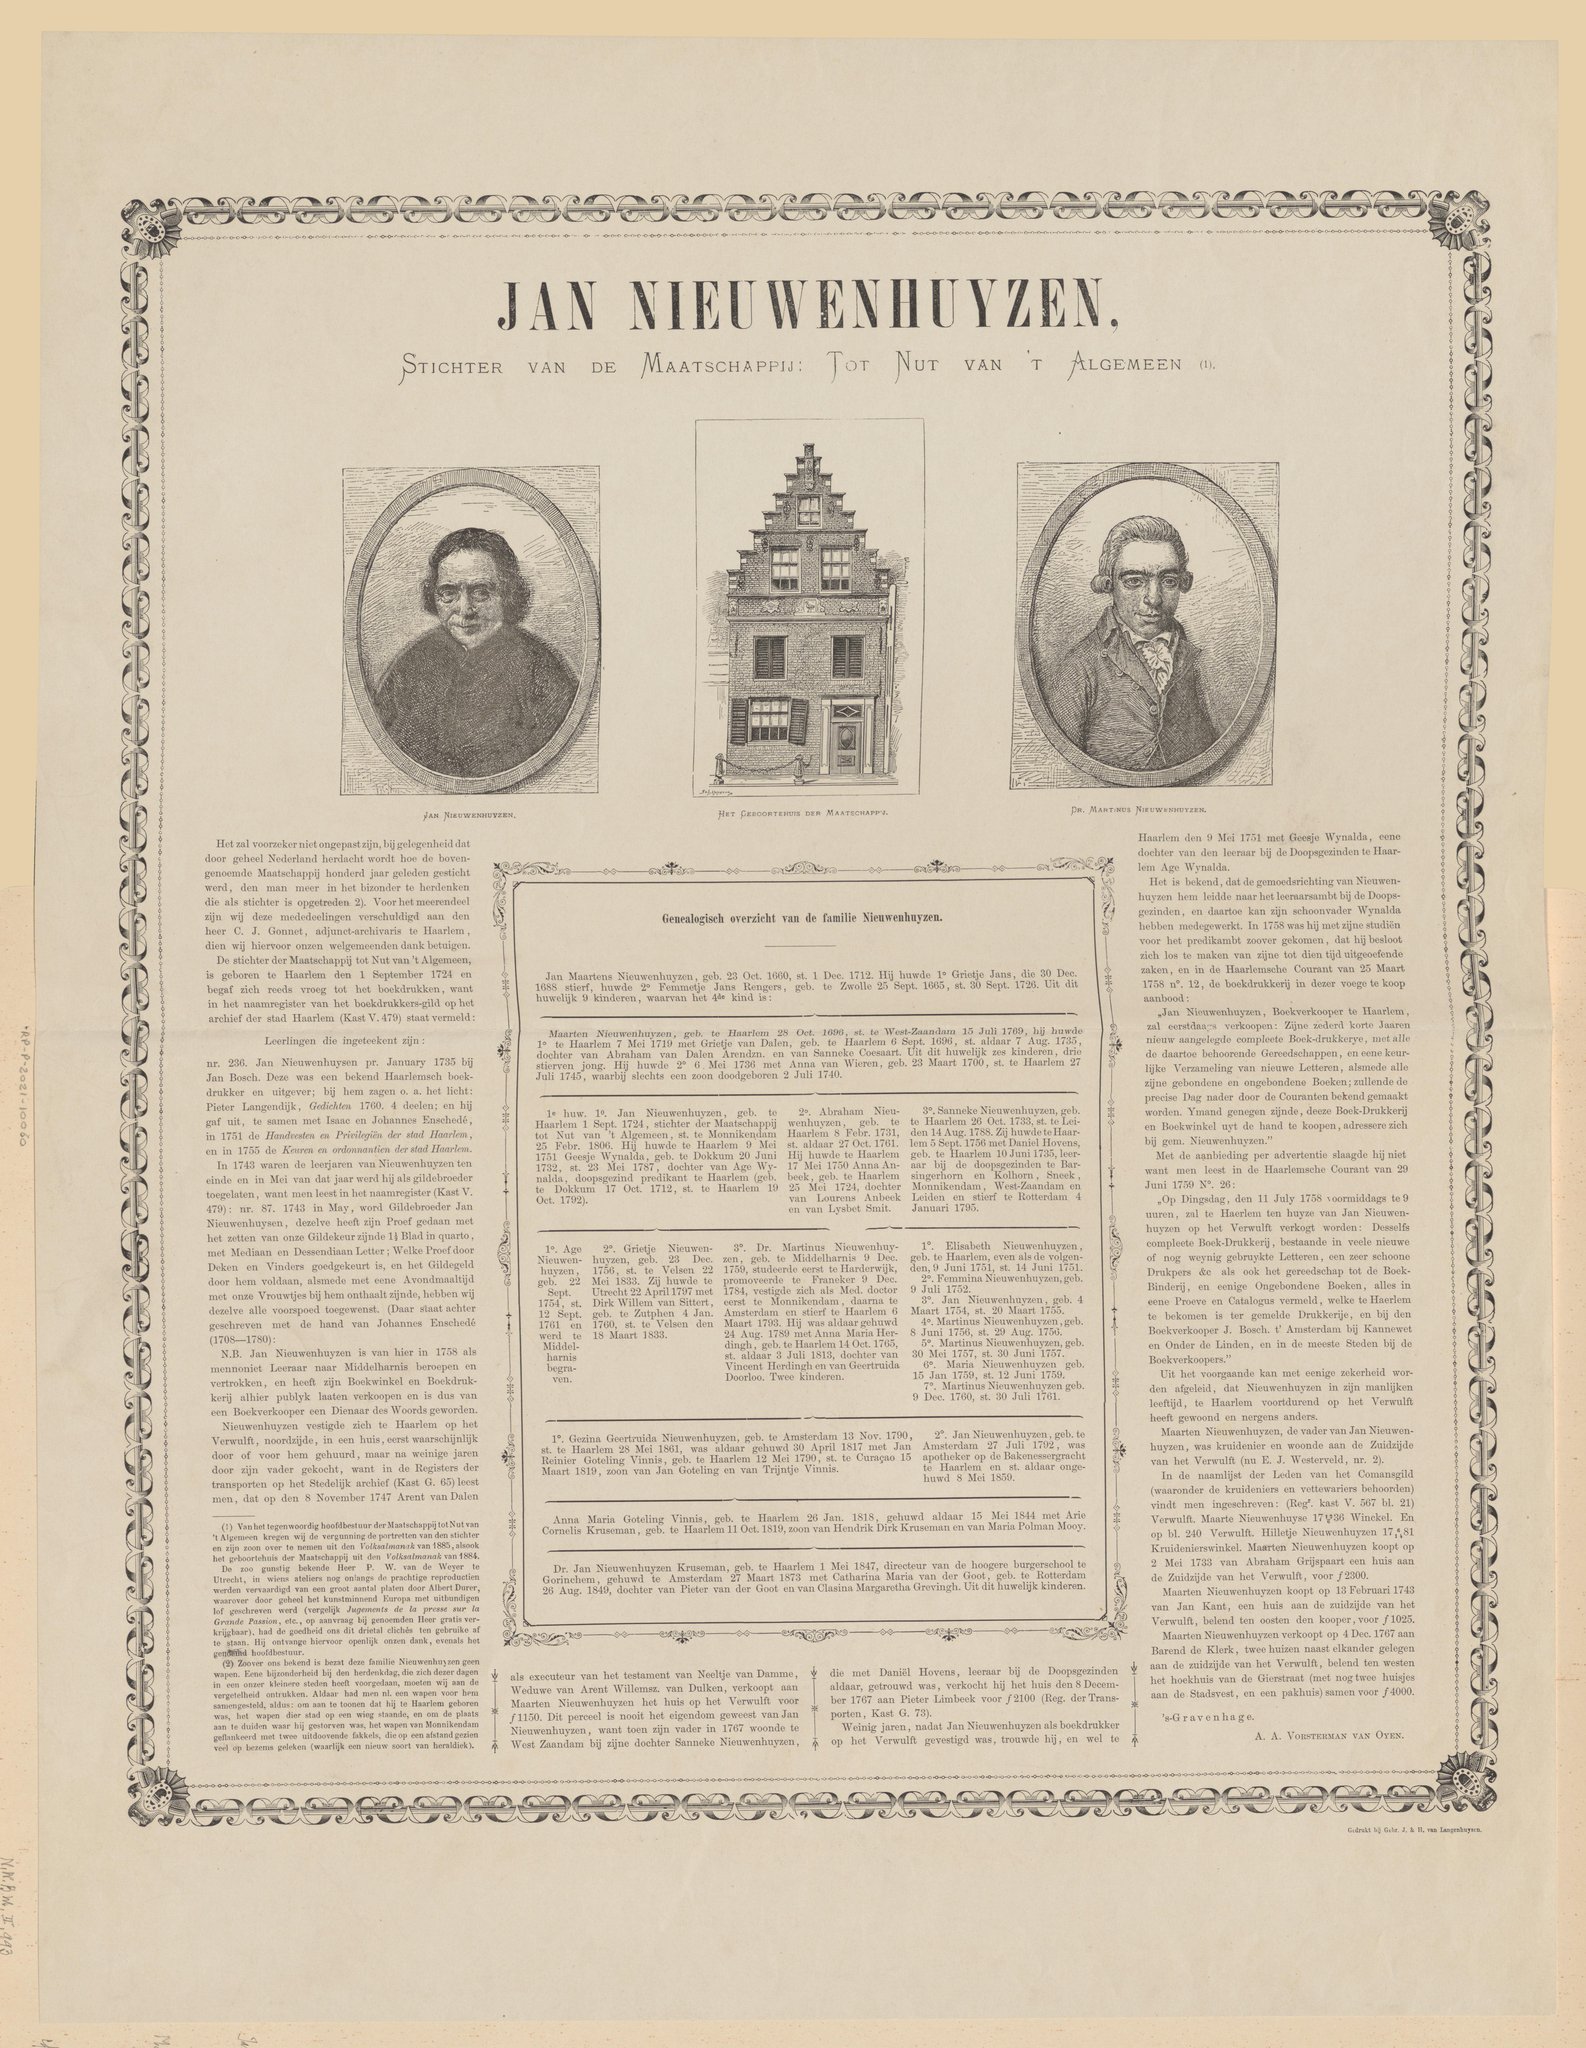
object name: print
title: Tekstblad met portretten van Jan en Martinus Nieuwenhuyzen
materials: paper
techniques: letterpress printing, printing block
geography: the hague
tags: haarlem, martinus nieuwenhuyzen, amsterdam, jan nieuwenhuyzen, historical persons, façade (of house or building)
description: Tussen de beide portretten het huis waar de Maatschappij tot nut van 't algemeen is opgericht.